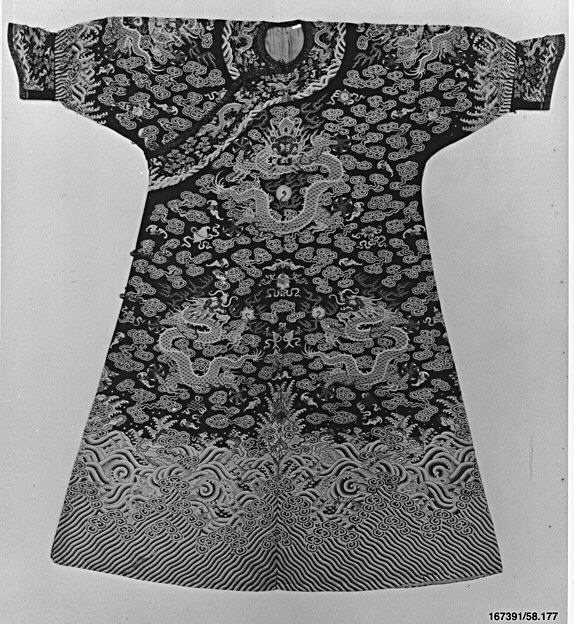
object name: robe, imperial court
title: Imperial Court Robe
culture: chinese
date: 1723-1735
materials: silk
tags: dragons